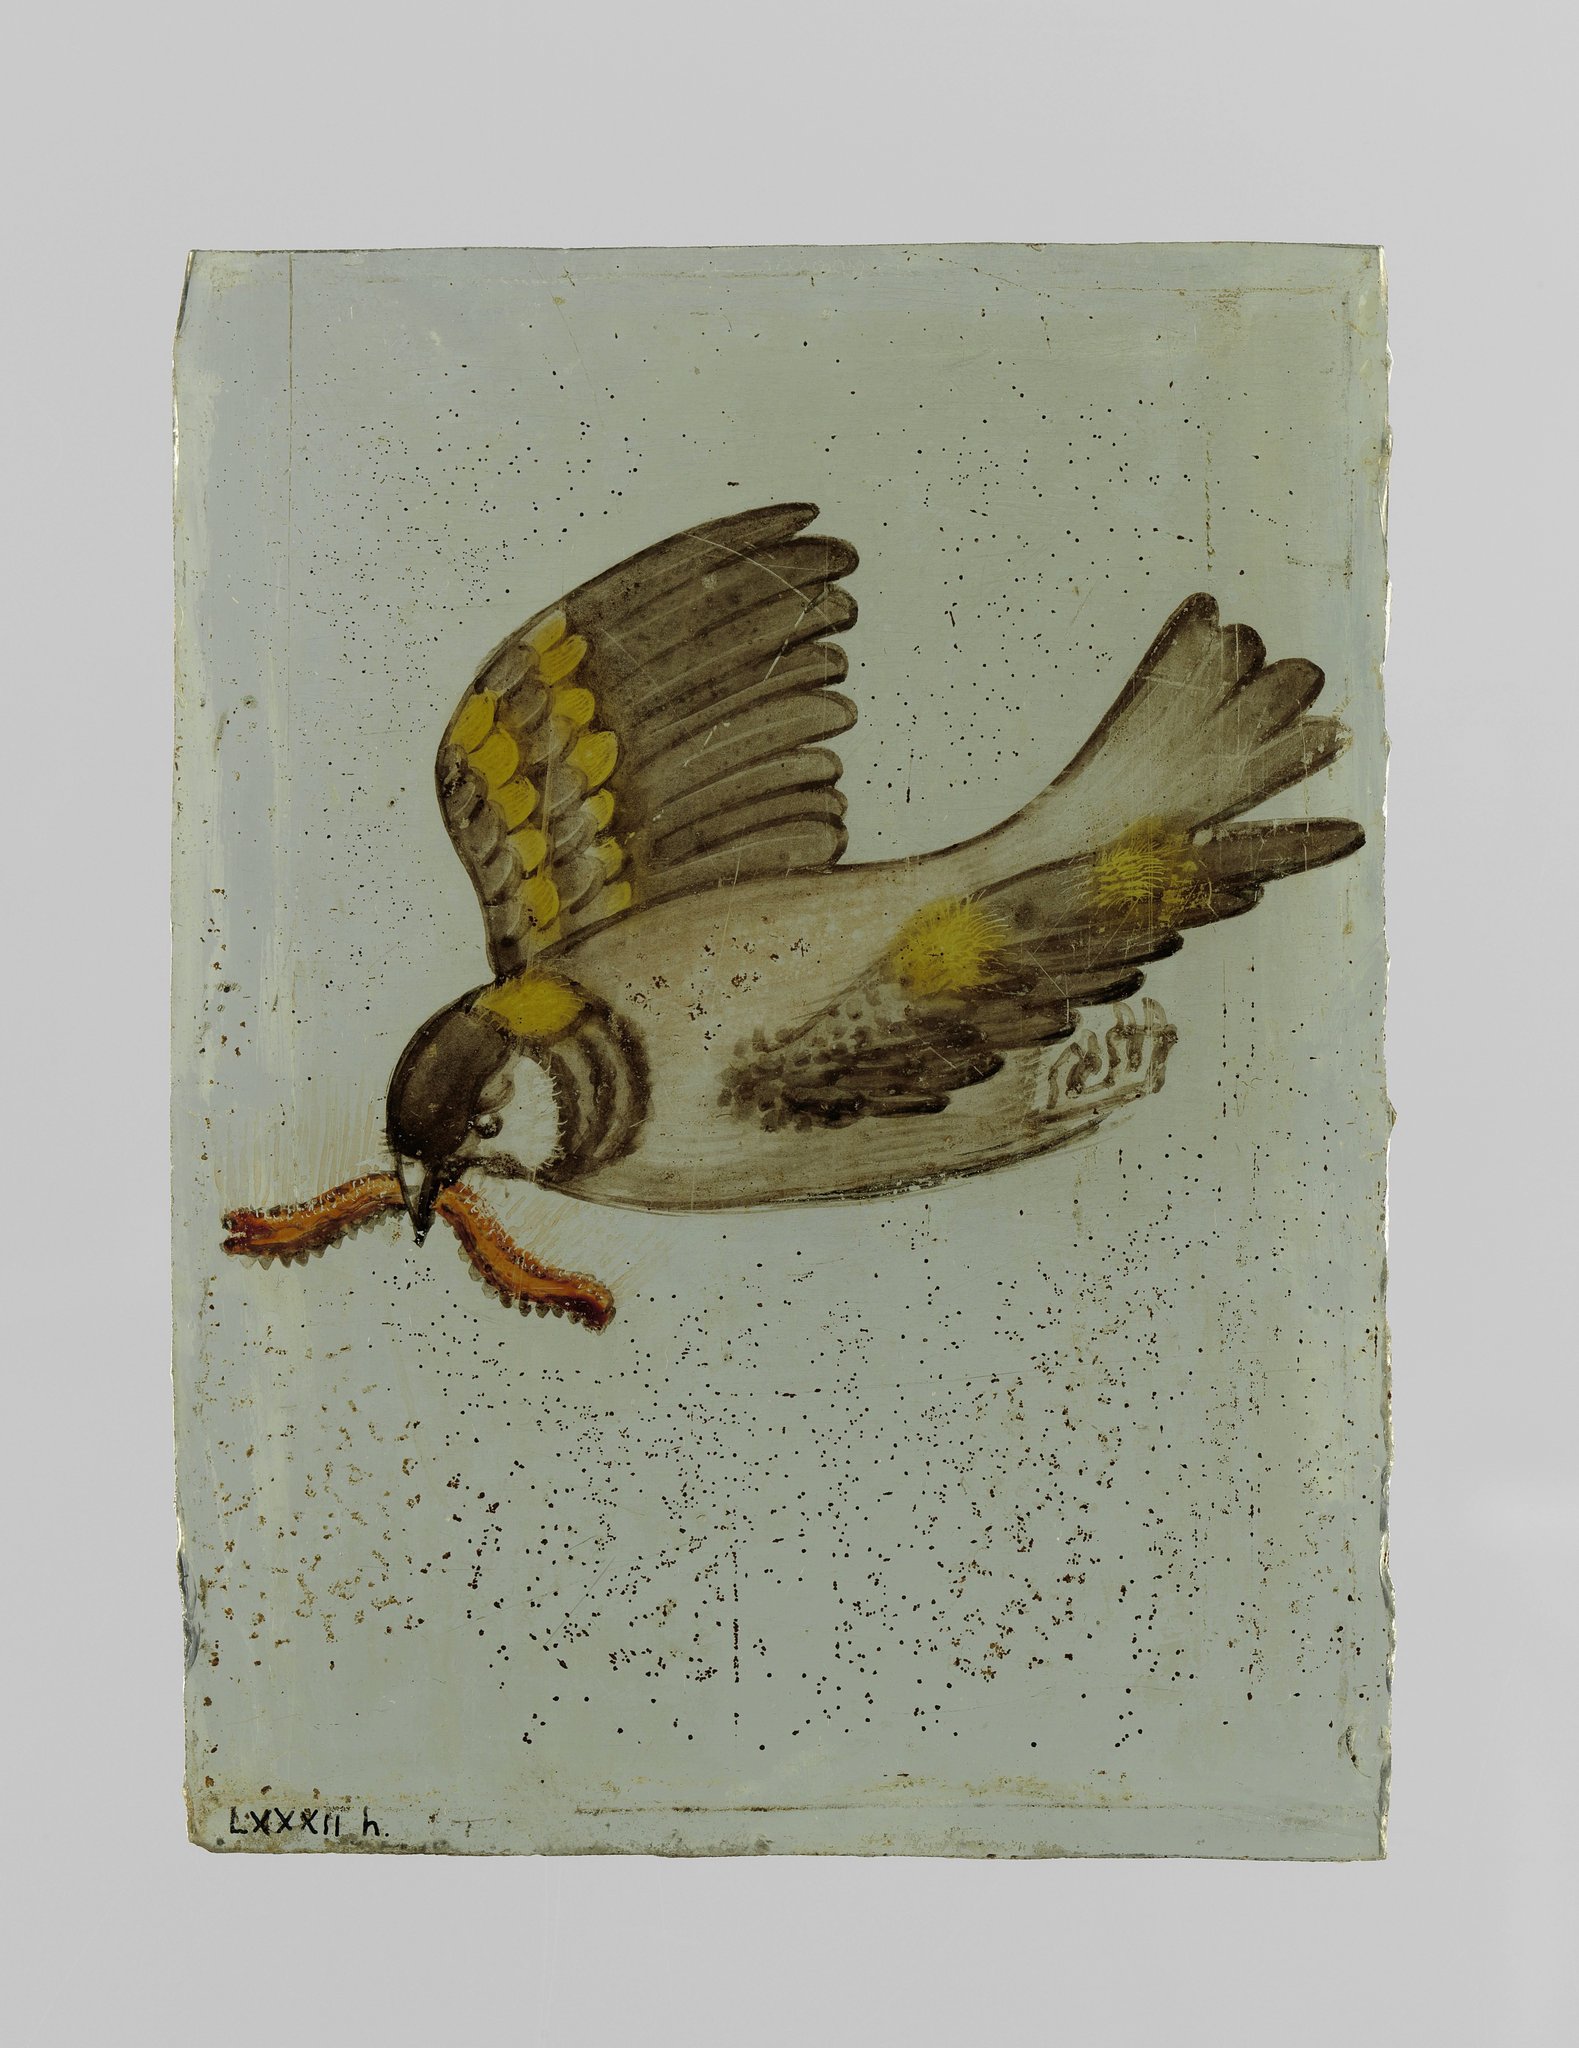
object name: light window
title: Ruit met een vliegende vogel met in zijn snavel een rups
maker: Anonymous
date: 1650-1675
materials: glass, lead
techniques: enamel painting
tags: birds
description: Een ruit met emailschildering van een wegvliegende vogel met in zijn snavel een rups.